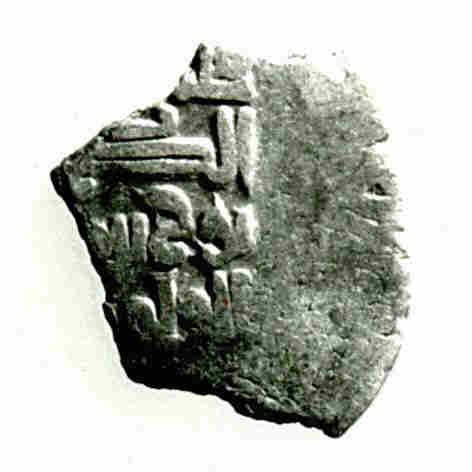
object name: coin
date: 976-997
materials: silver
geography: iran